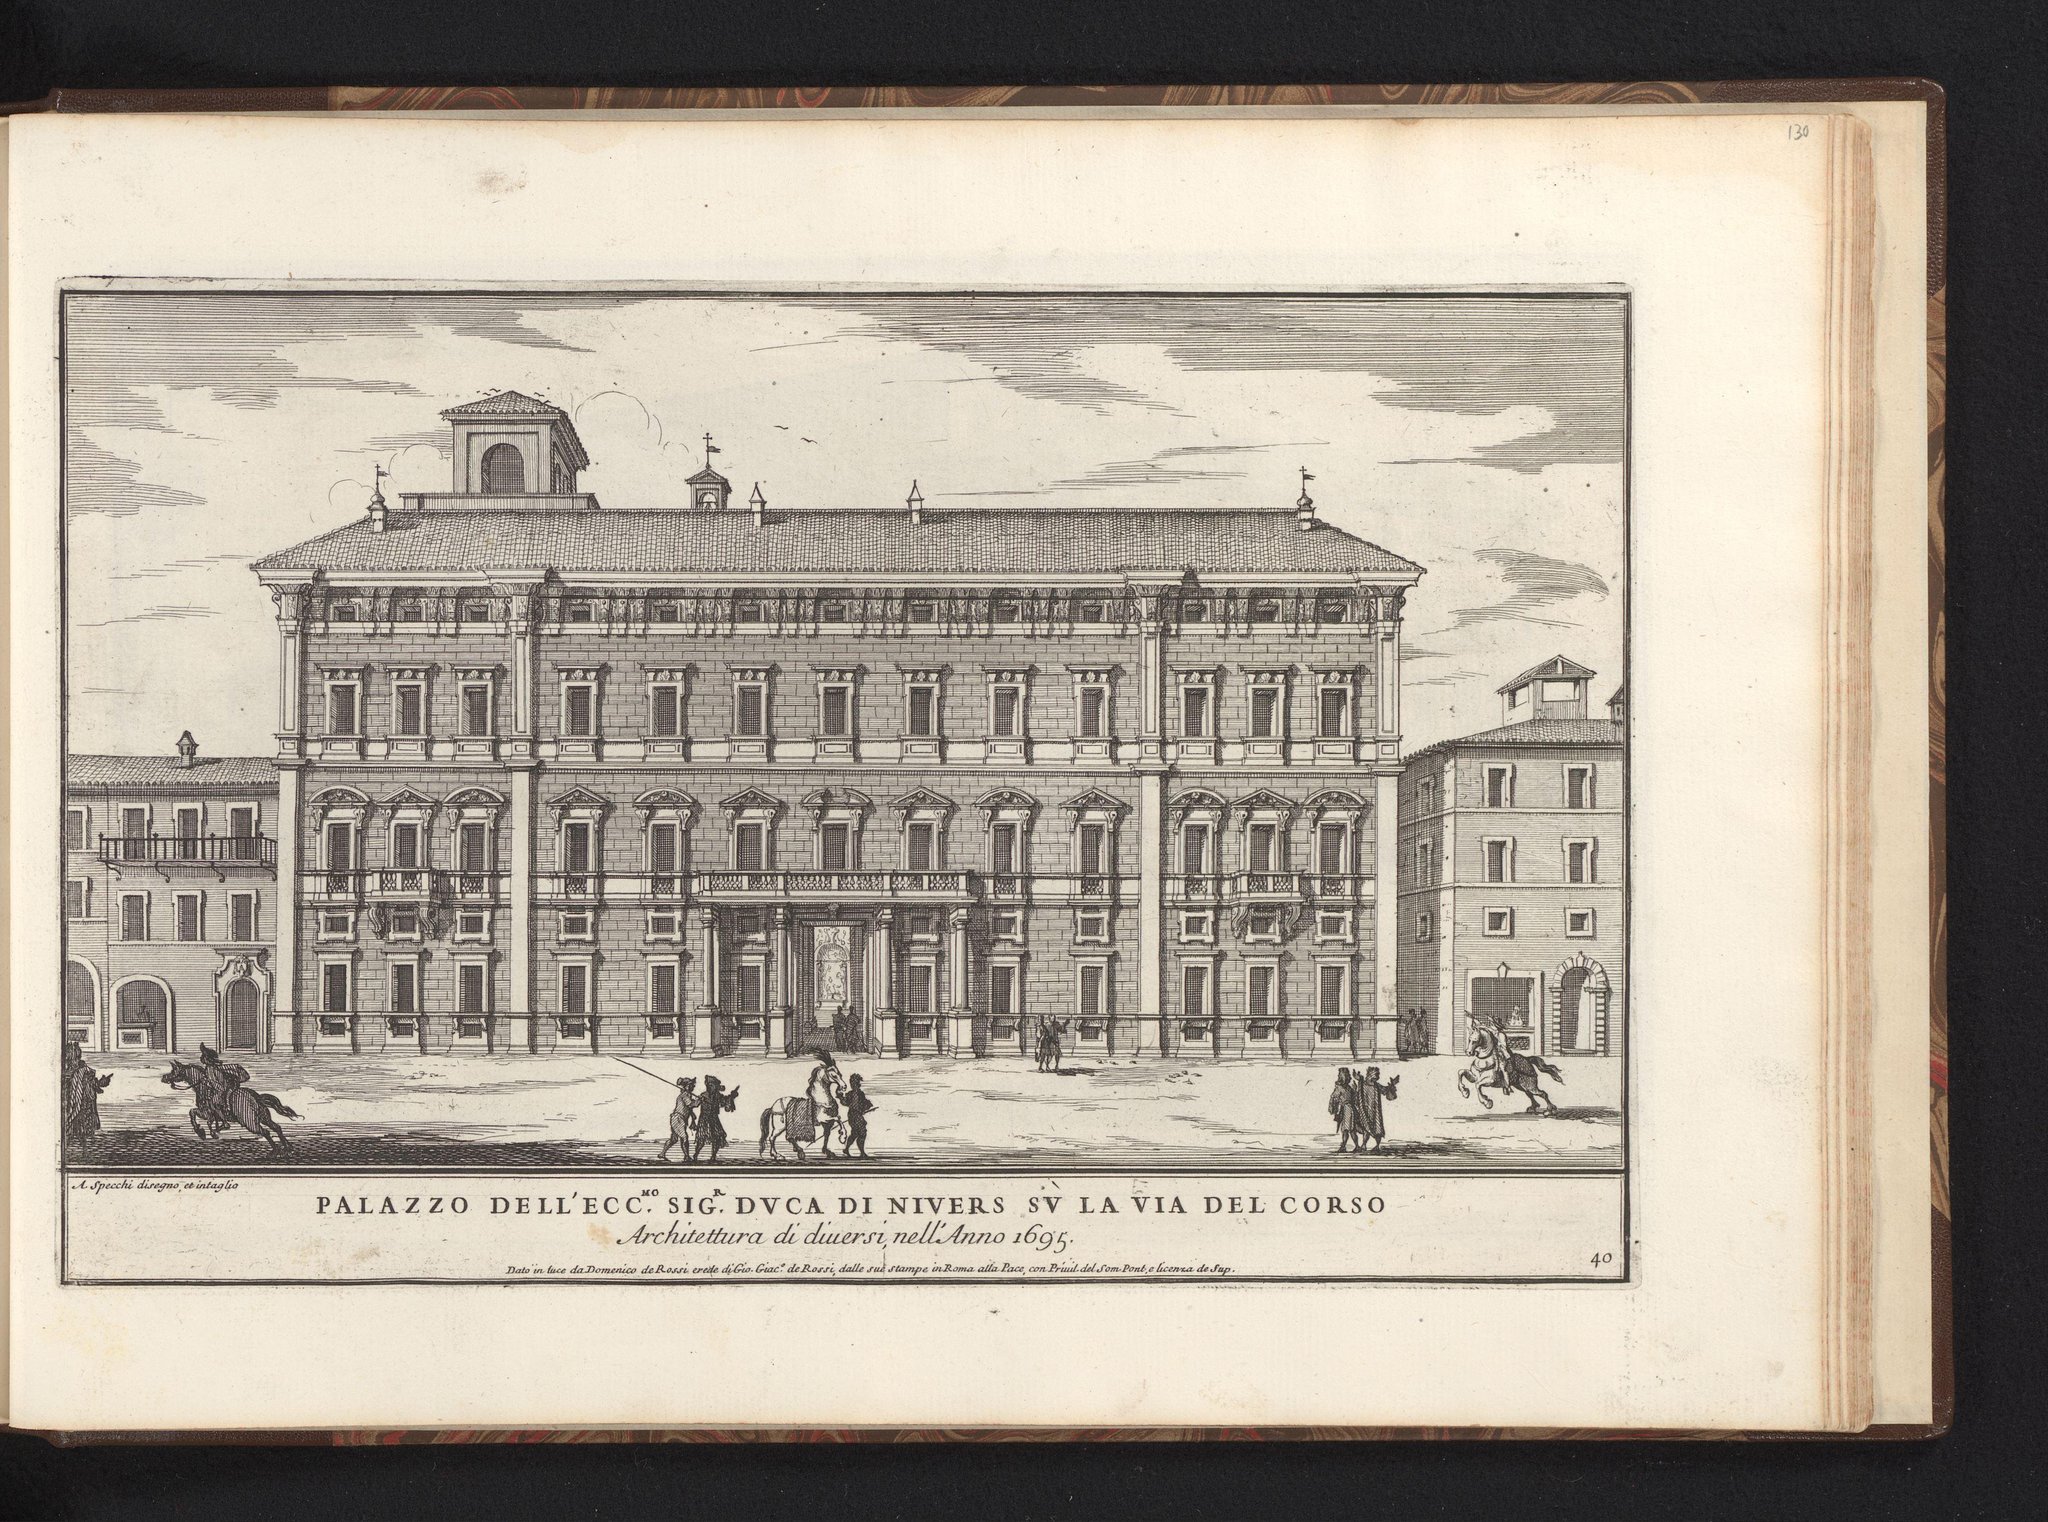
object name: print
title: Palazzo Mancini te Rome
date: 1699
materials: paper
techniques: etching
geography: italy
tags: city-view, and landscape with man-made constructions, hôtel, i.e. small palace in city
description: Deze prent maakt deel uit van een reeks van 52 prenten met voorstellingen van paleizen in Rome. Samen met vier andere reeksen vormt het de grote reeks: 'Il nuovo teatro di Roma moderna'.